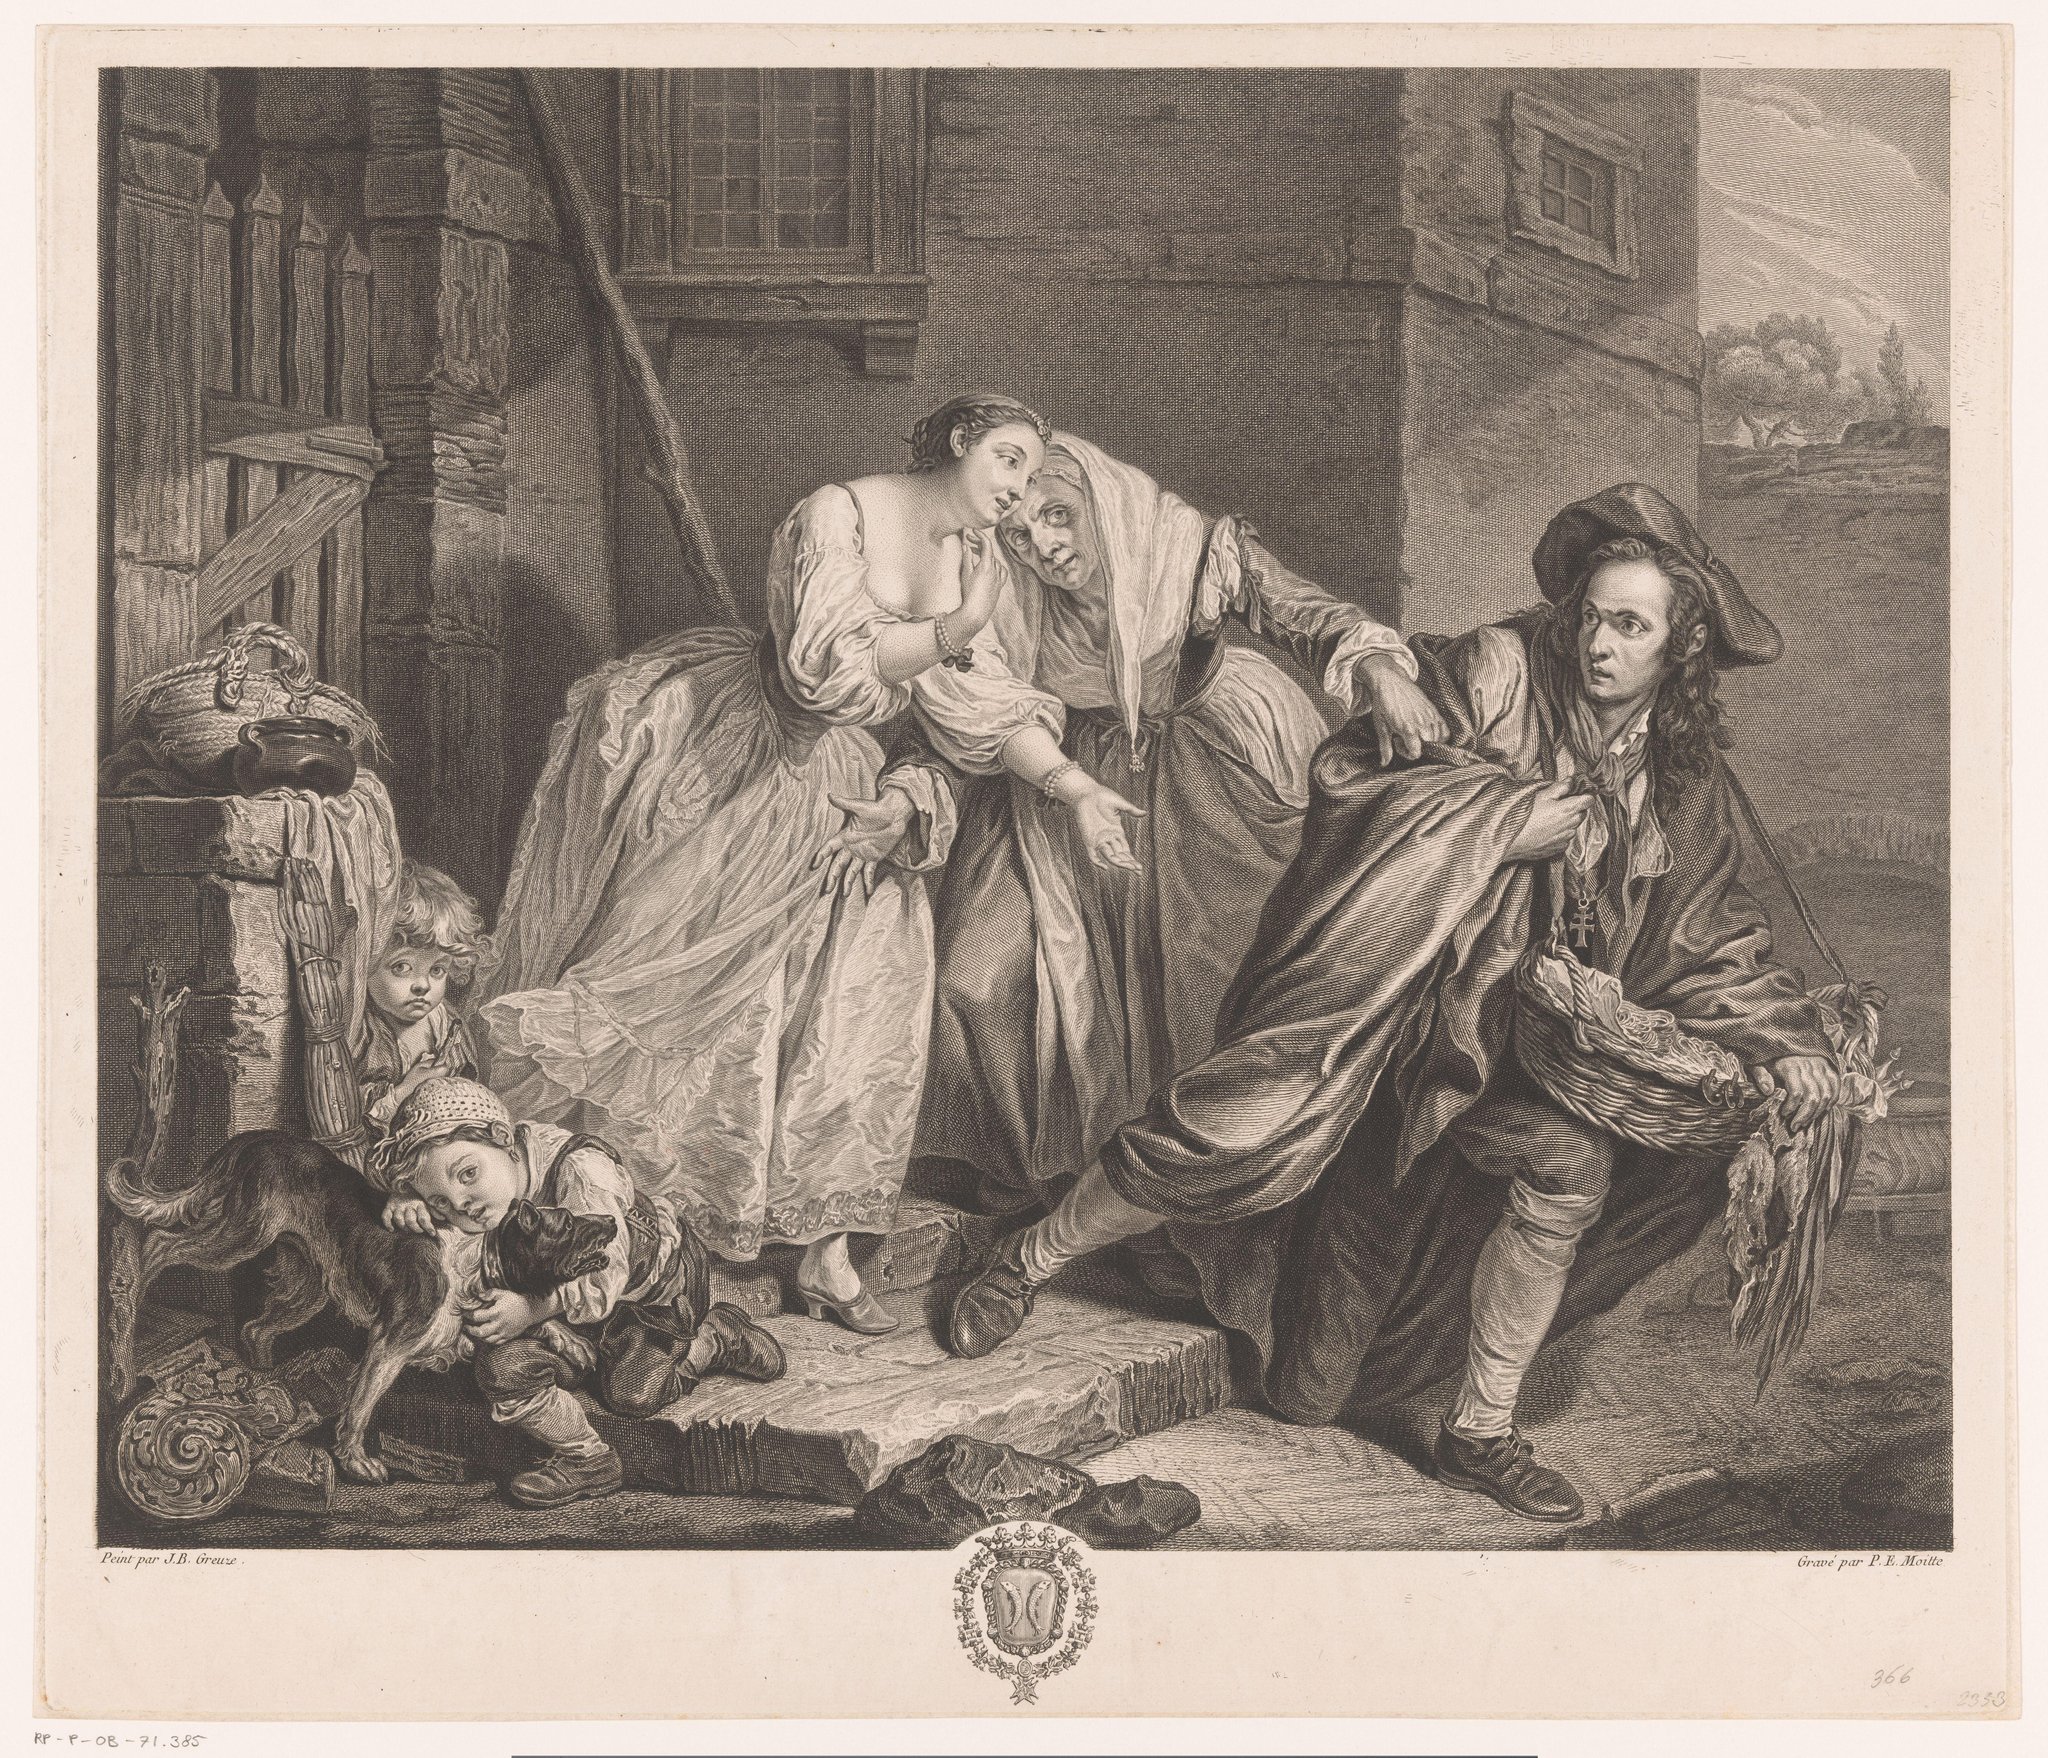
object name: print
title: Jonge en oude vrouw nemen afscheid van een marskramer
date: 1757-1780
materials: paper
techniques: engraving, etching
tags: gesture-language, rejection, pedlar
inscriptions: collector's mark: Lugt 240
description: Een jonge en oude vrouw staan voor een huis met twee jonge kinderen en een hond. De oude vrouw heeft haar hand op de schouder van een vertrekkende marskramer. De jonge vrouw houdt haar linkerhand onder haar kin en maakt een 'napoleontisch gebaar' (la geste napolitain) dat symbool staat voor afwijzing.